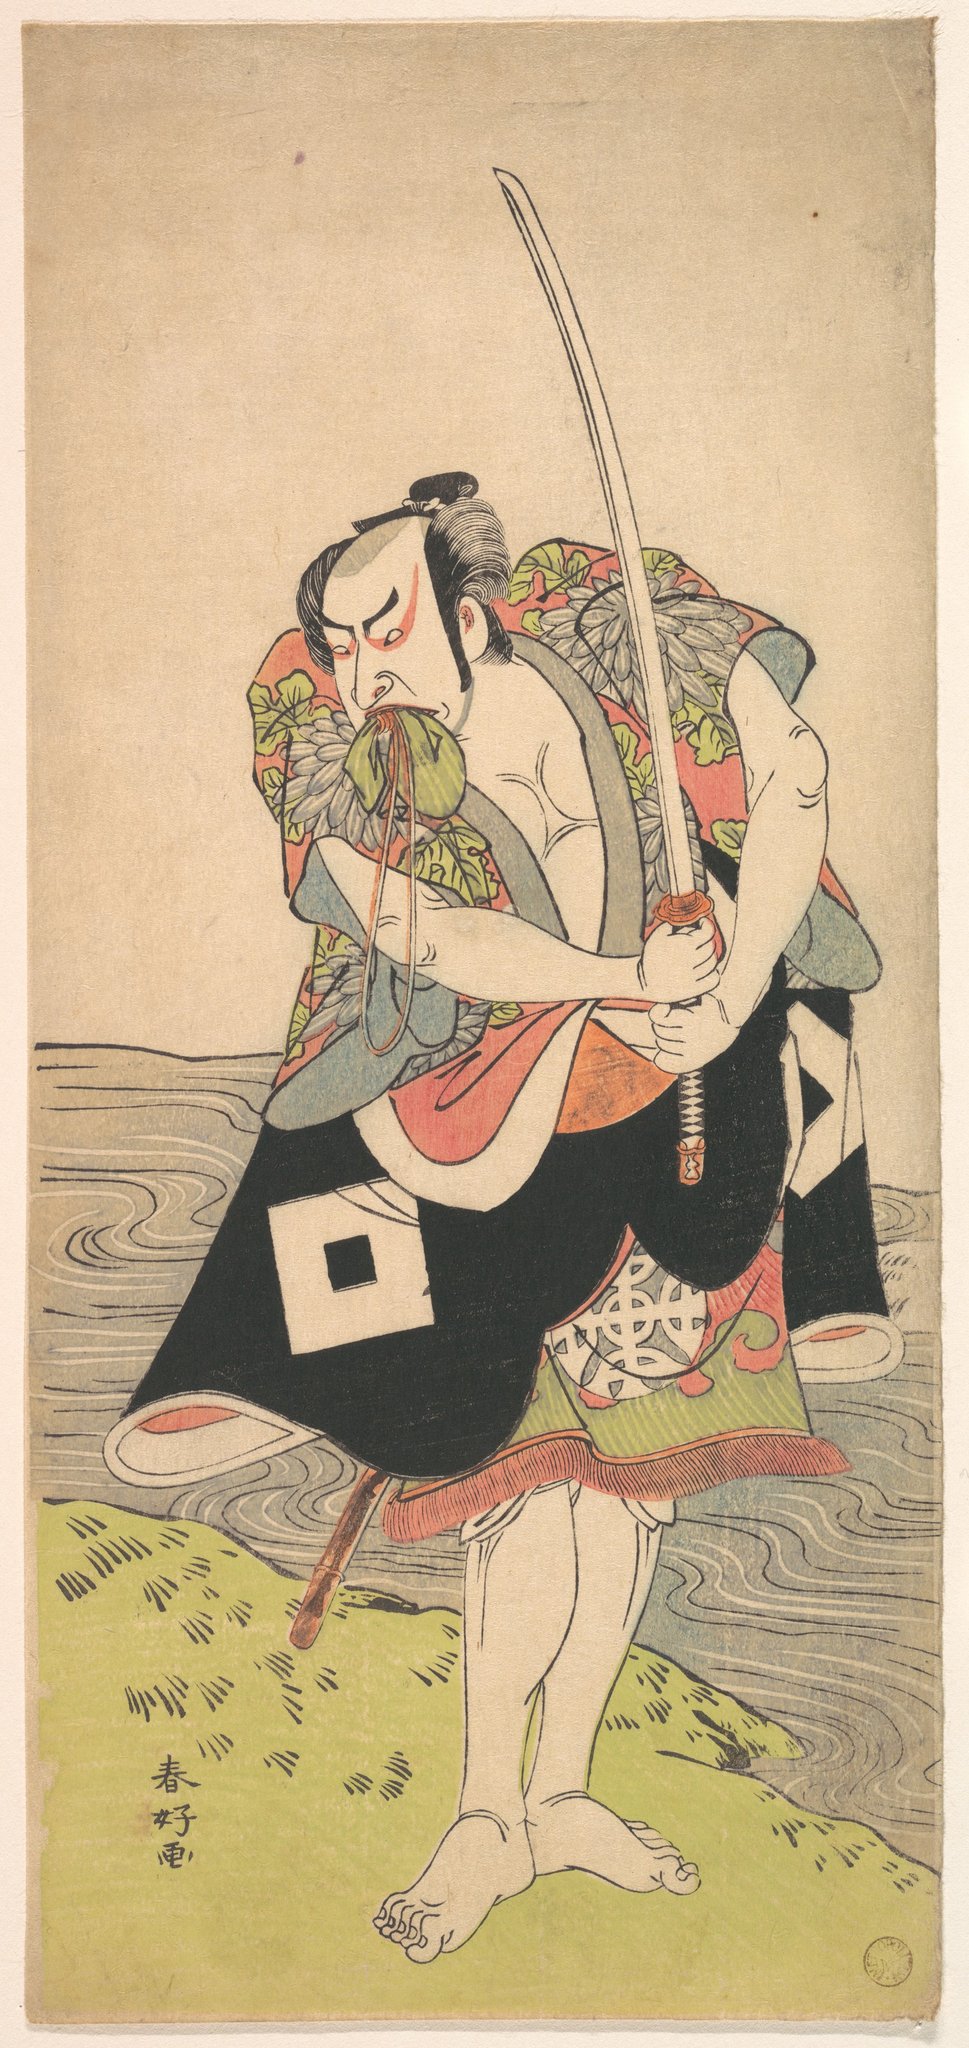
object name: print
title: The Actor Nakamura Nakazo with Drawn Sword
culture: japanese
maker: katsukawa shunkō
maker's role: artist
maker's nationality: japanese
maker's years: 1743-1812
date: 1790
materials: ink, paper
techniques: woodblock print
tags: swords,men,actors